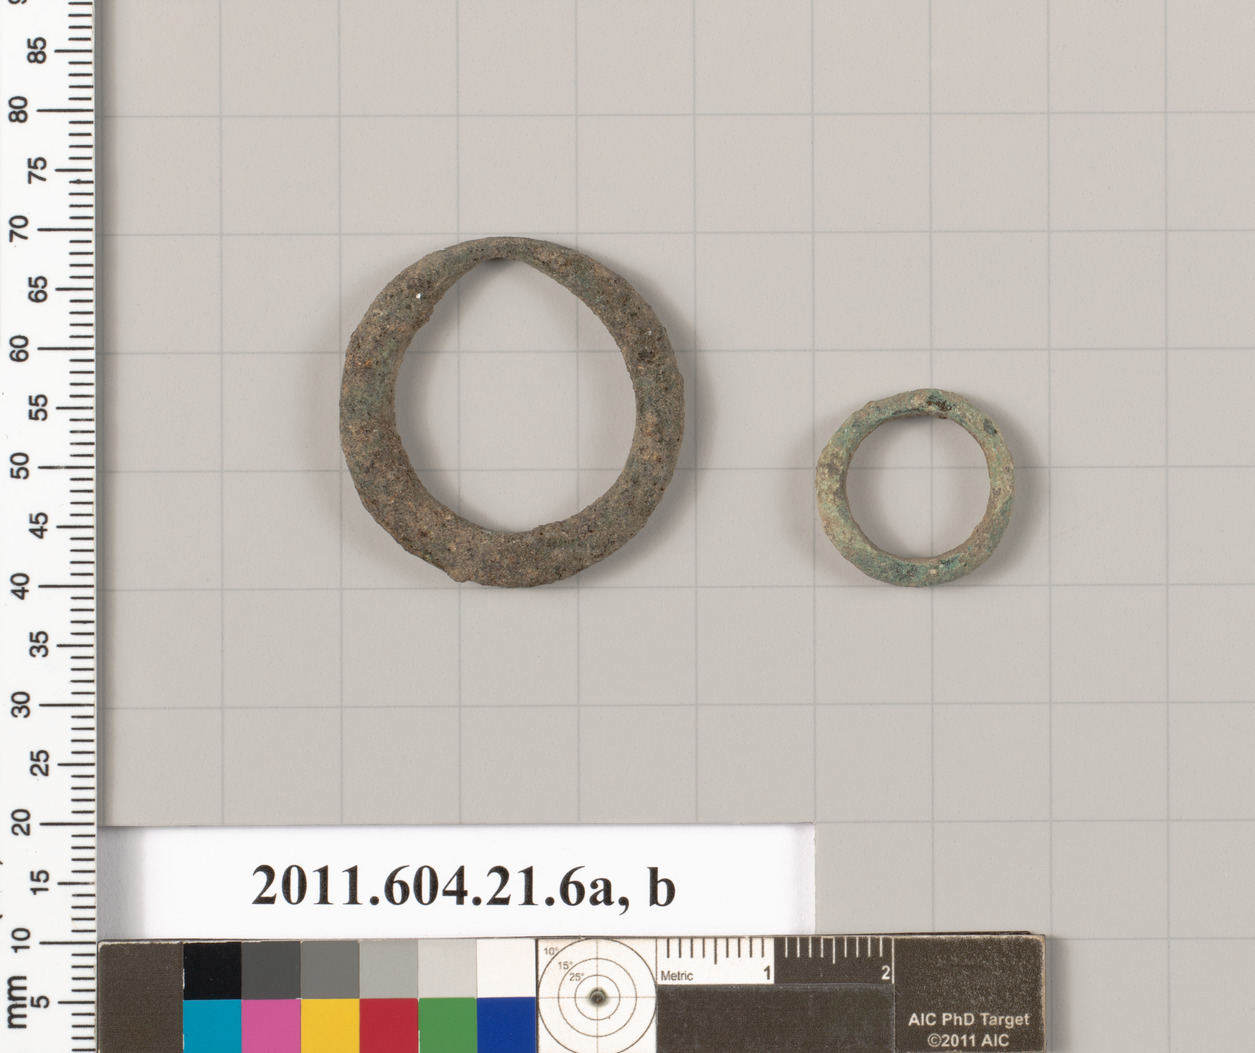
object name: bronze ring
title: Bronze rings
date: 600-401 BCE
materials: bronze